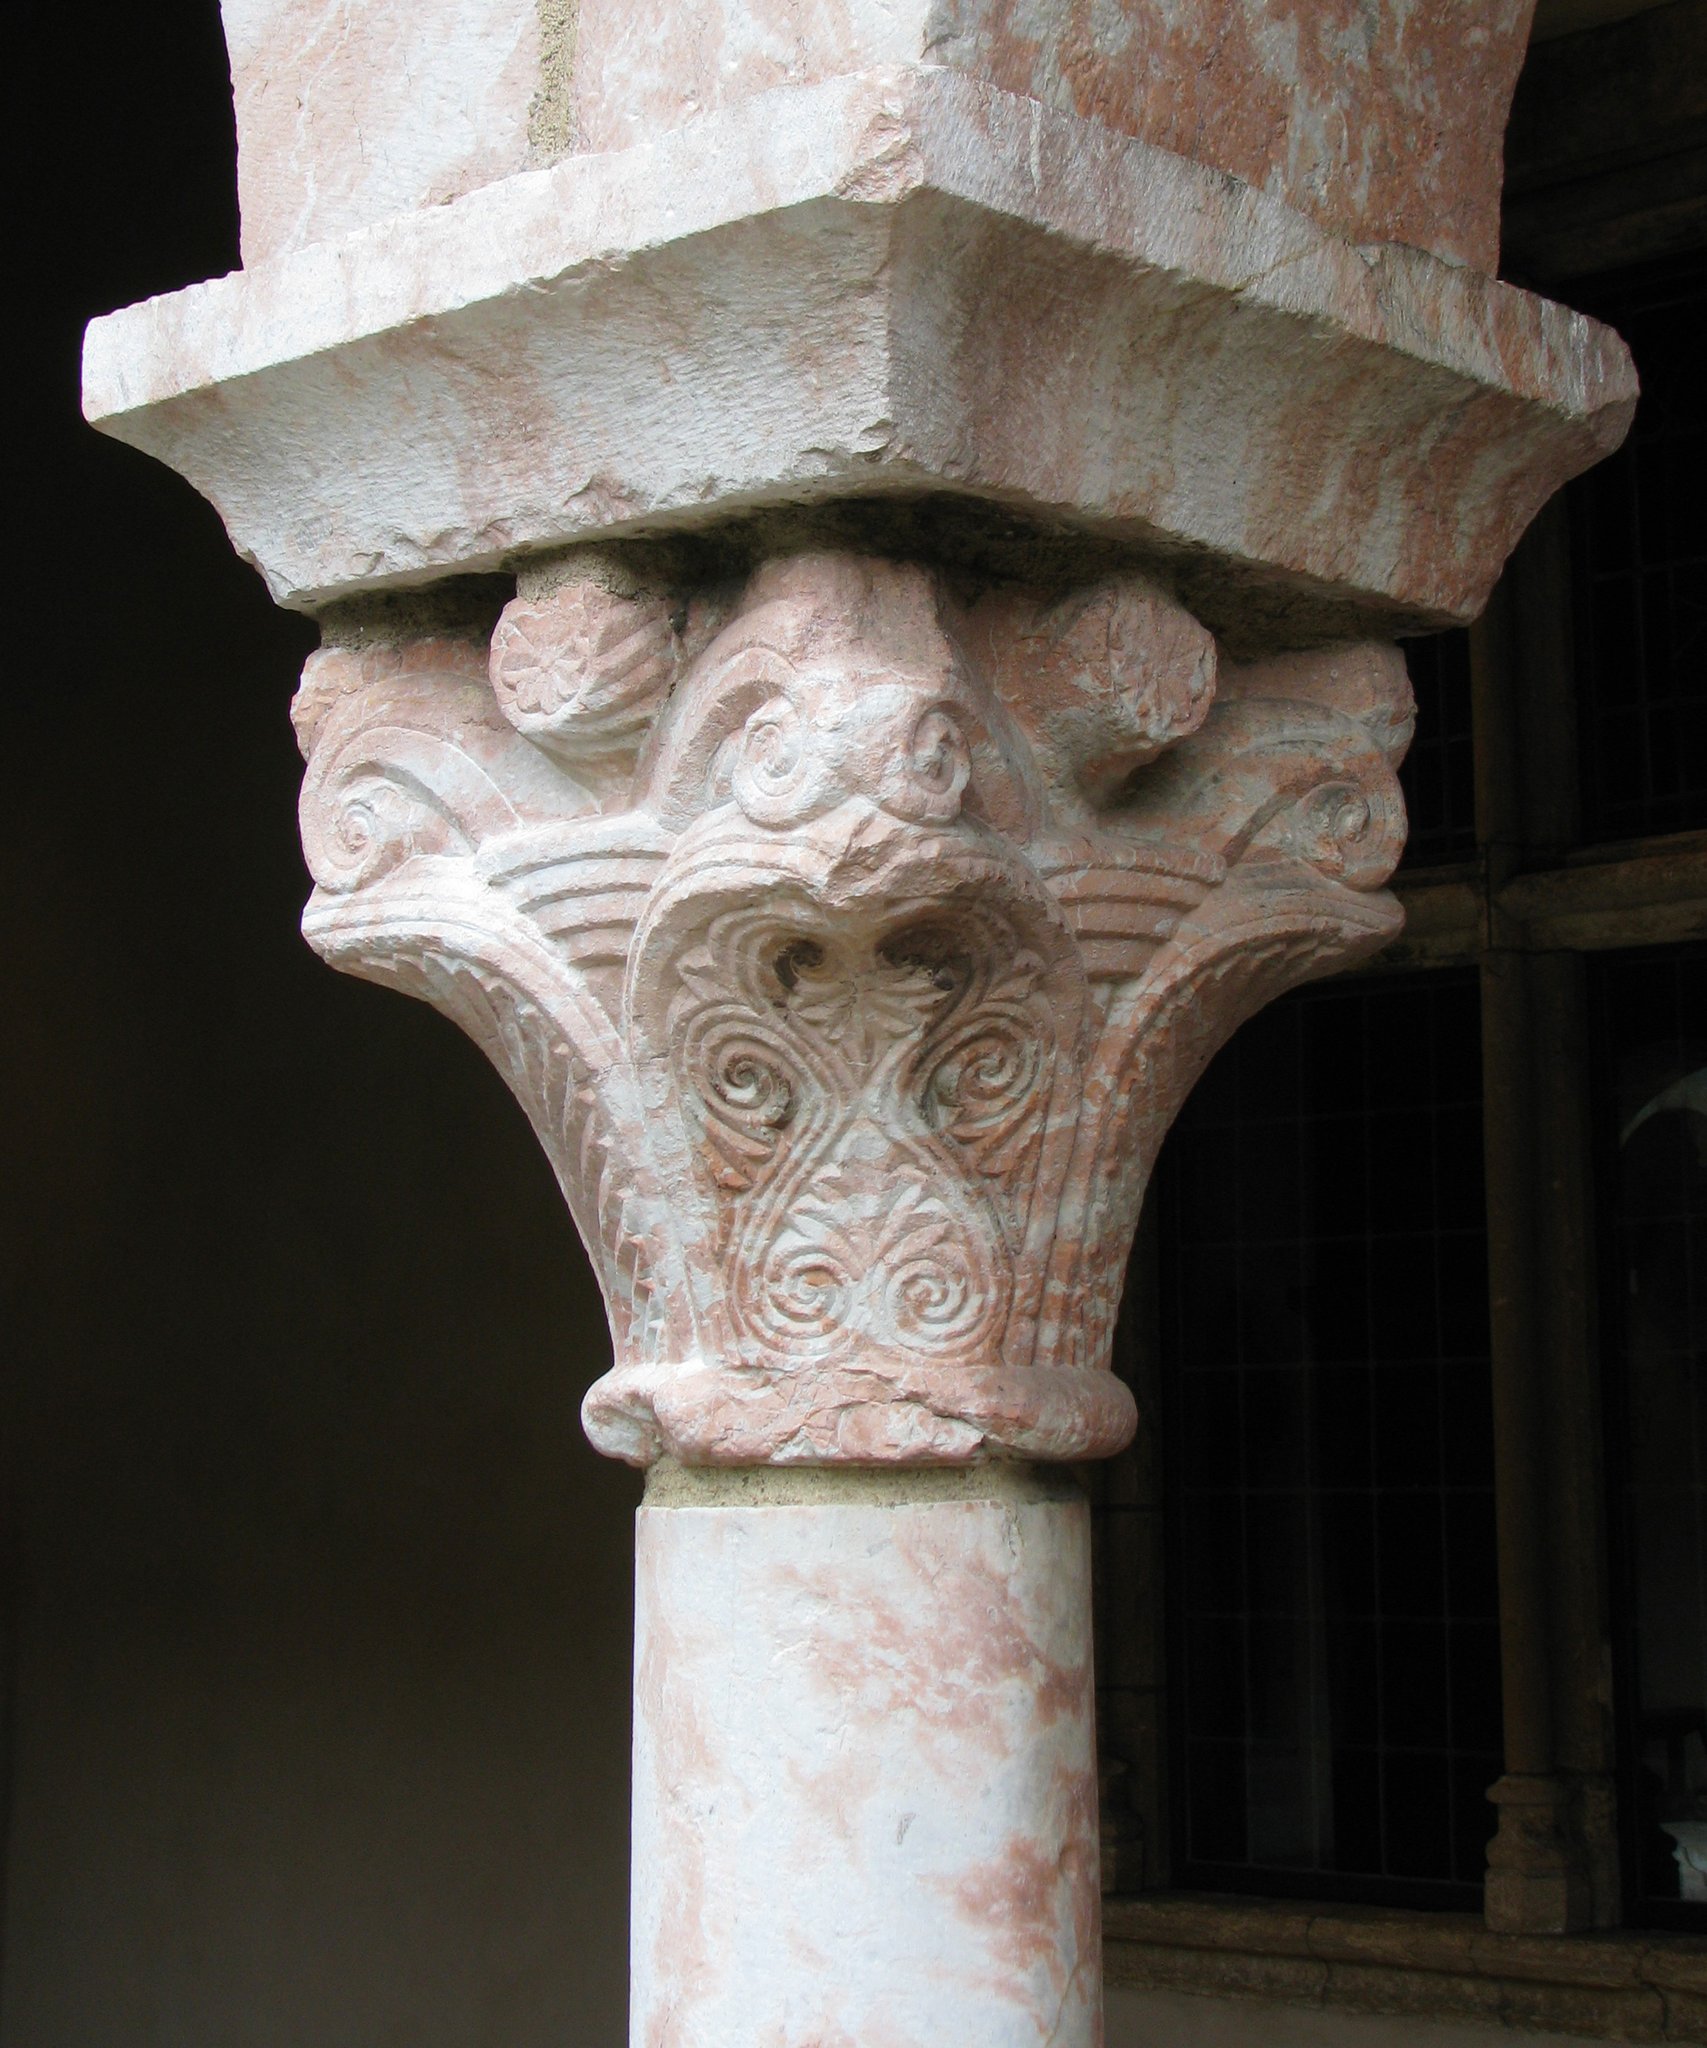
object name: capital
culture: catalan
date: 1130-1140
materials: marble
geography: france